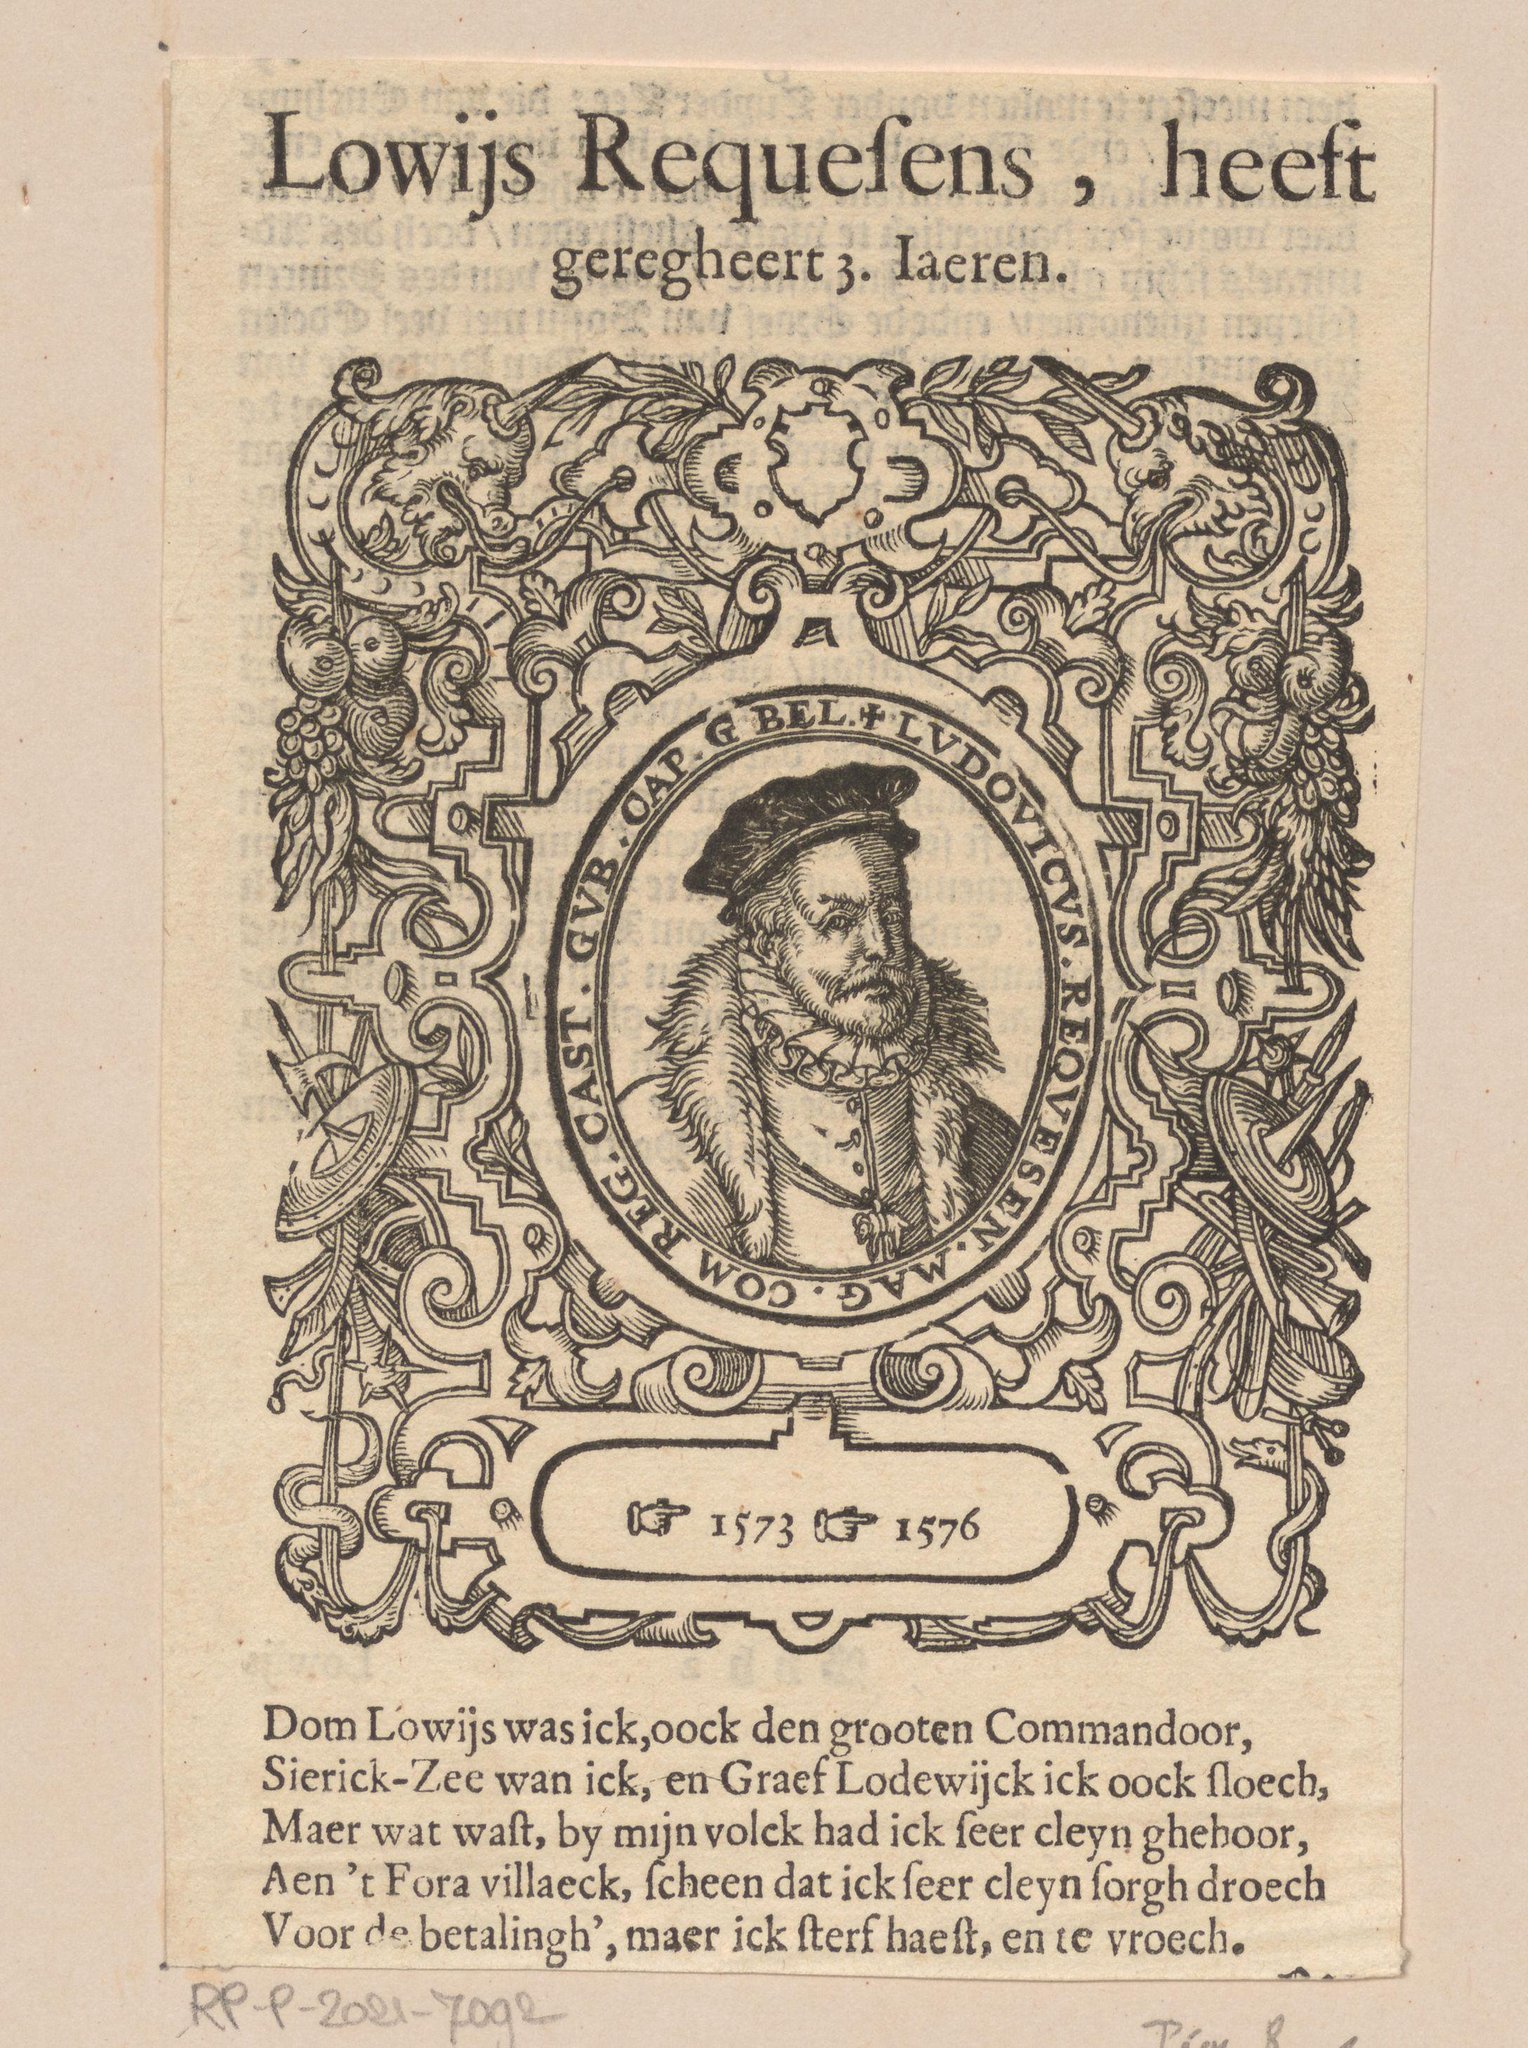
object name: book illustration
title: Portret van Luis de Zúñiga y Requesens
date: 1636-1646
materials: paper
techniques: letterpress printing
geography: amsterdam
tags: brussels, mayor, luis de zúñiga y requesens, historical persons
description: Prent uit: Scriverius, Petrus. Corte historische beschryvinghe der Nederlandtsche oorlogen (...). Amsterdam: Broer Jansz., 1646. Of uit een eerdere editie (1636).